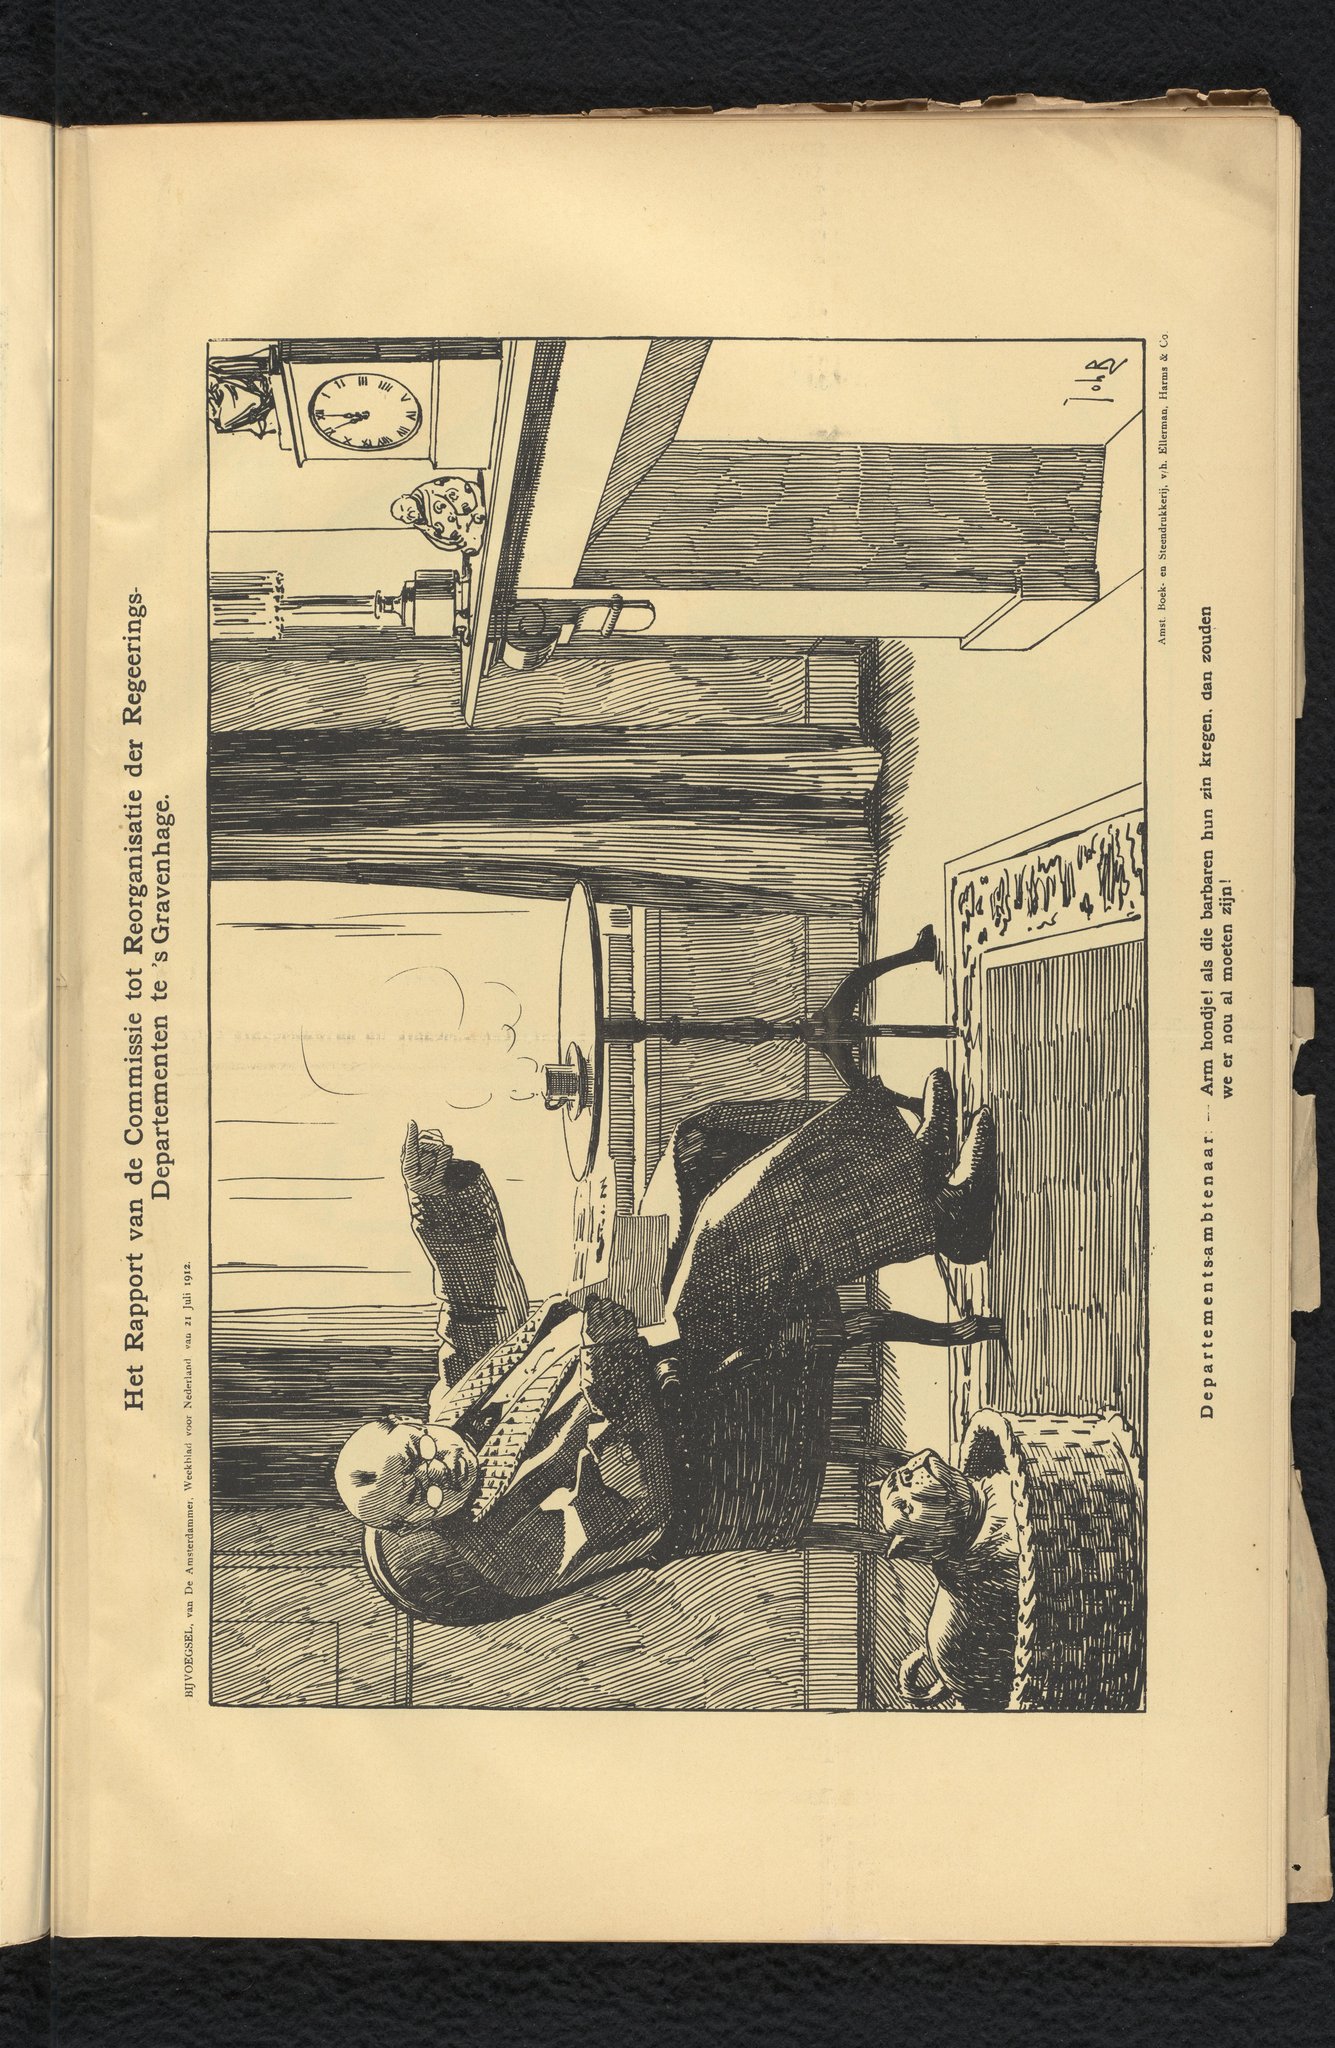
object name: cartoon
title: Het Rapport van de Commissie tot Reorganisatie der Regeerings-Departementen te 's Gravenhage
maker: johan braakensiek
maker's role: draughtsman, print maker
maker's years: 1858-1940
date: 1912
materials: paper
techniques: lithograph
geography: amsterdam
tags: national government, political caricatures and satires, dog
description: Een ministeriële ambtenaar in zijn kamerjas zittend in een stoel spreekt tot zijn hond.